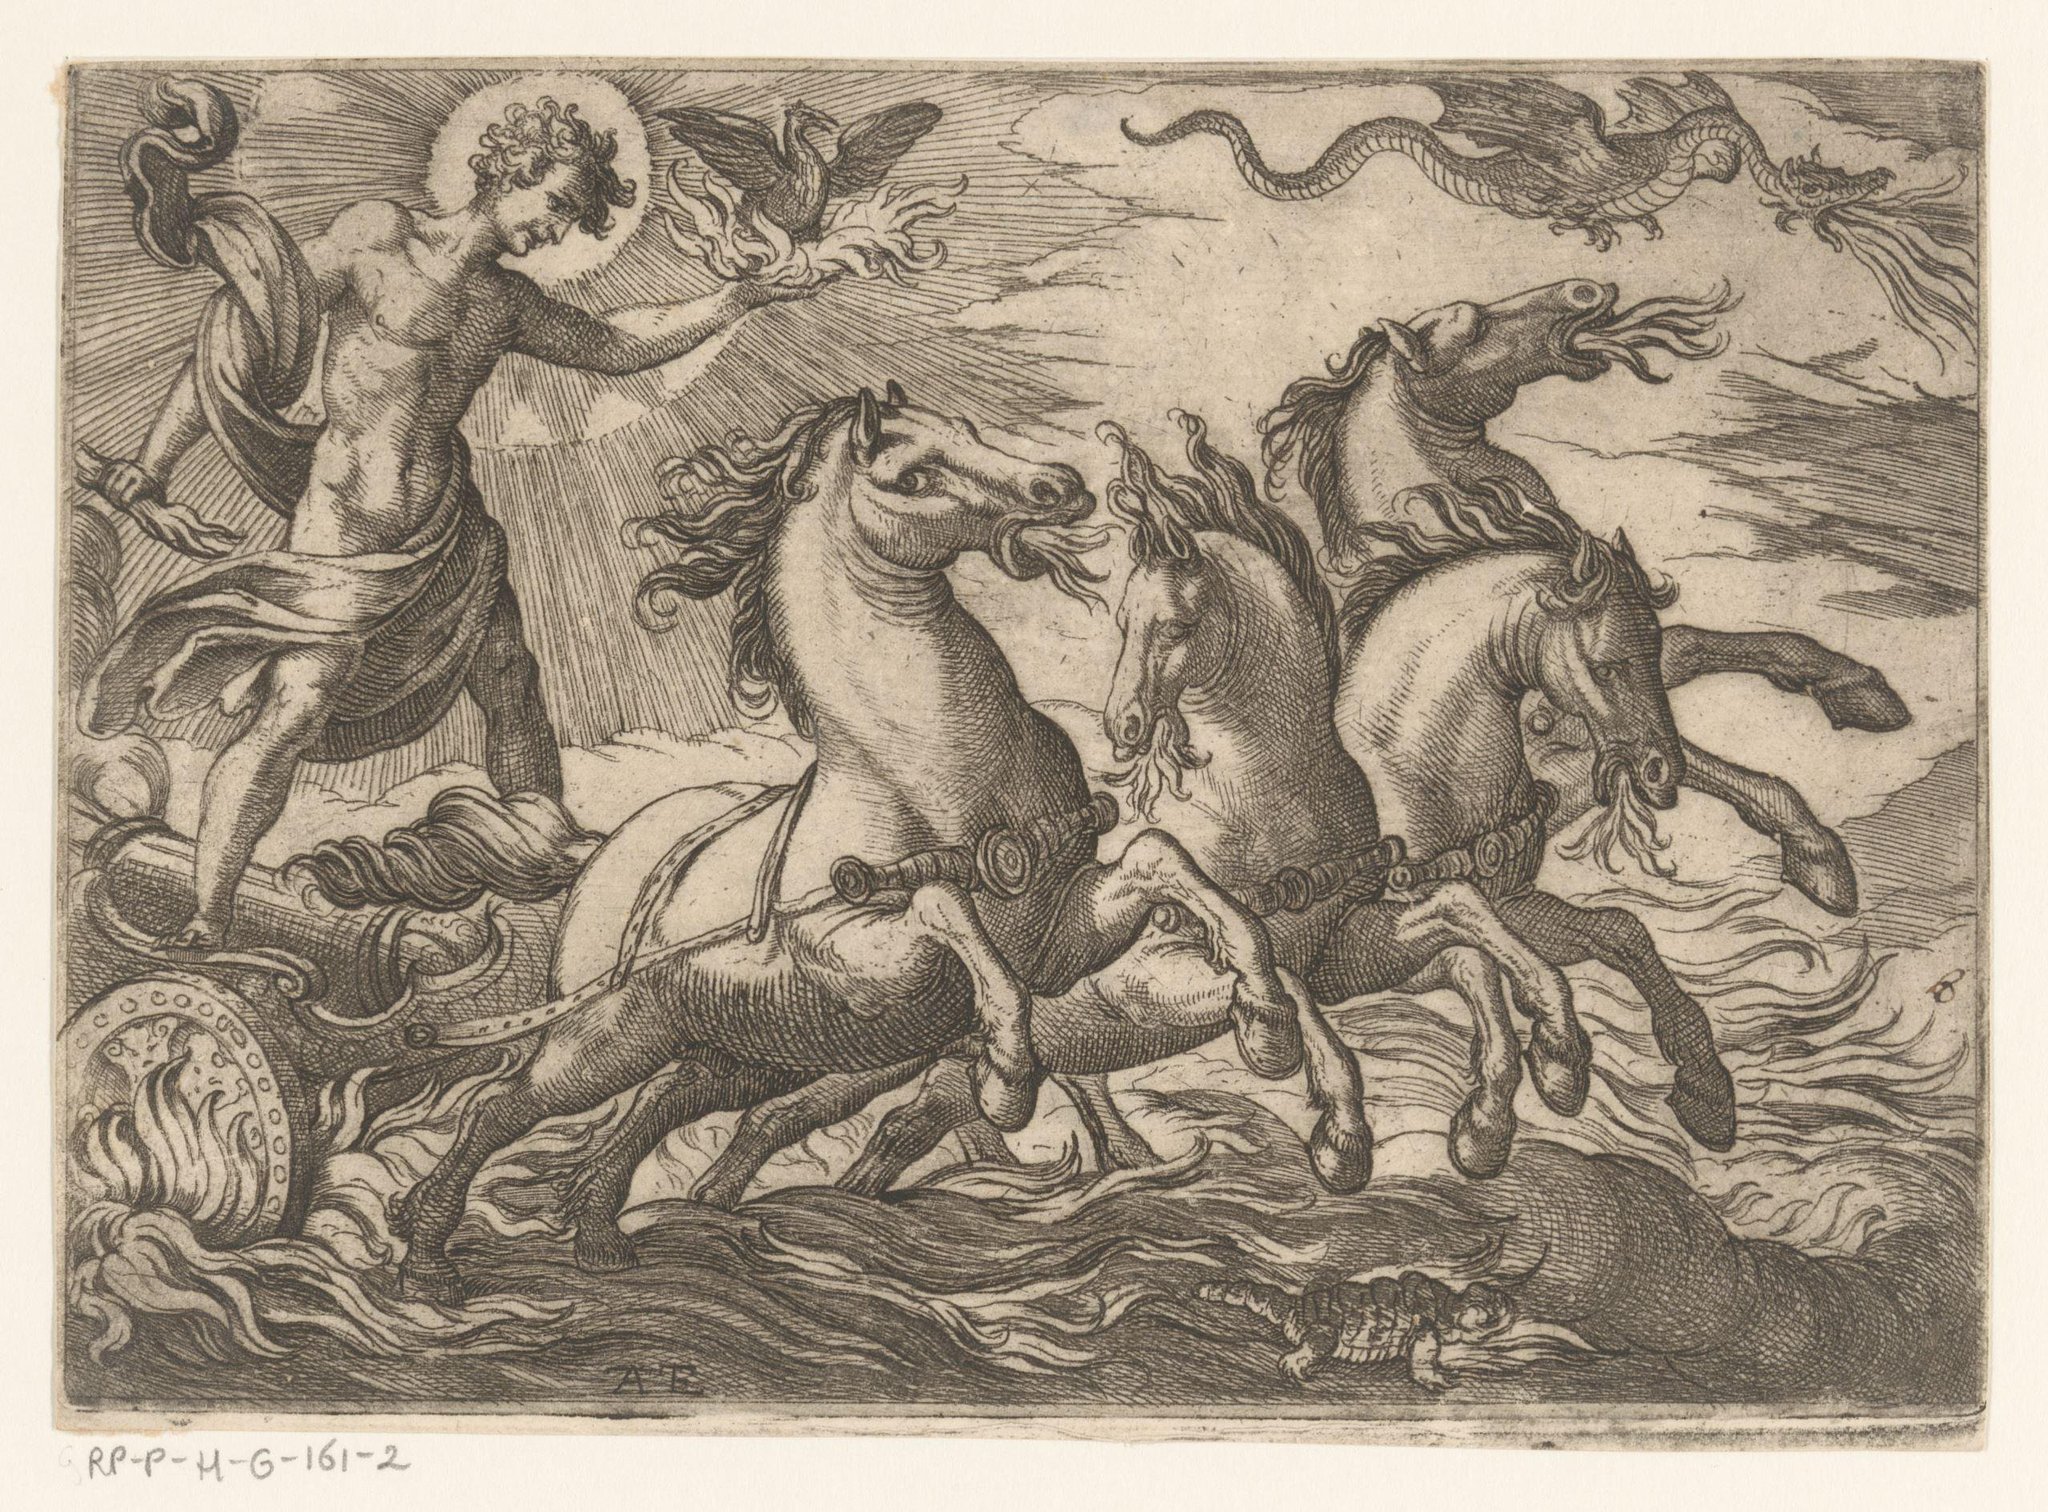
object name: print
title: Vuur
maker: antonio tempesta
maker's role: draughtsman, painter, print maker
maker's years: 1555-1630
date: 1565-1630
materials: paper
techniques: etching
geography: italy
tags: fire (one of the four elements), 'fuoco', 'carro del fuoco' (ripa)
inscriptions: collector's mark: ‘Hinloopen’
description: De mannelijke personificatie van het element vuur op een wagen met brandende wielen die wordt voortgetrokken door vier vuurspuwende paarden. Op de hand van de man zit een feniks. In de lucht vliegt een draak.